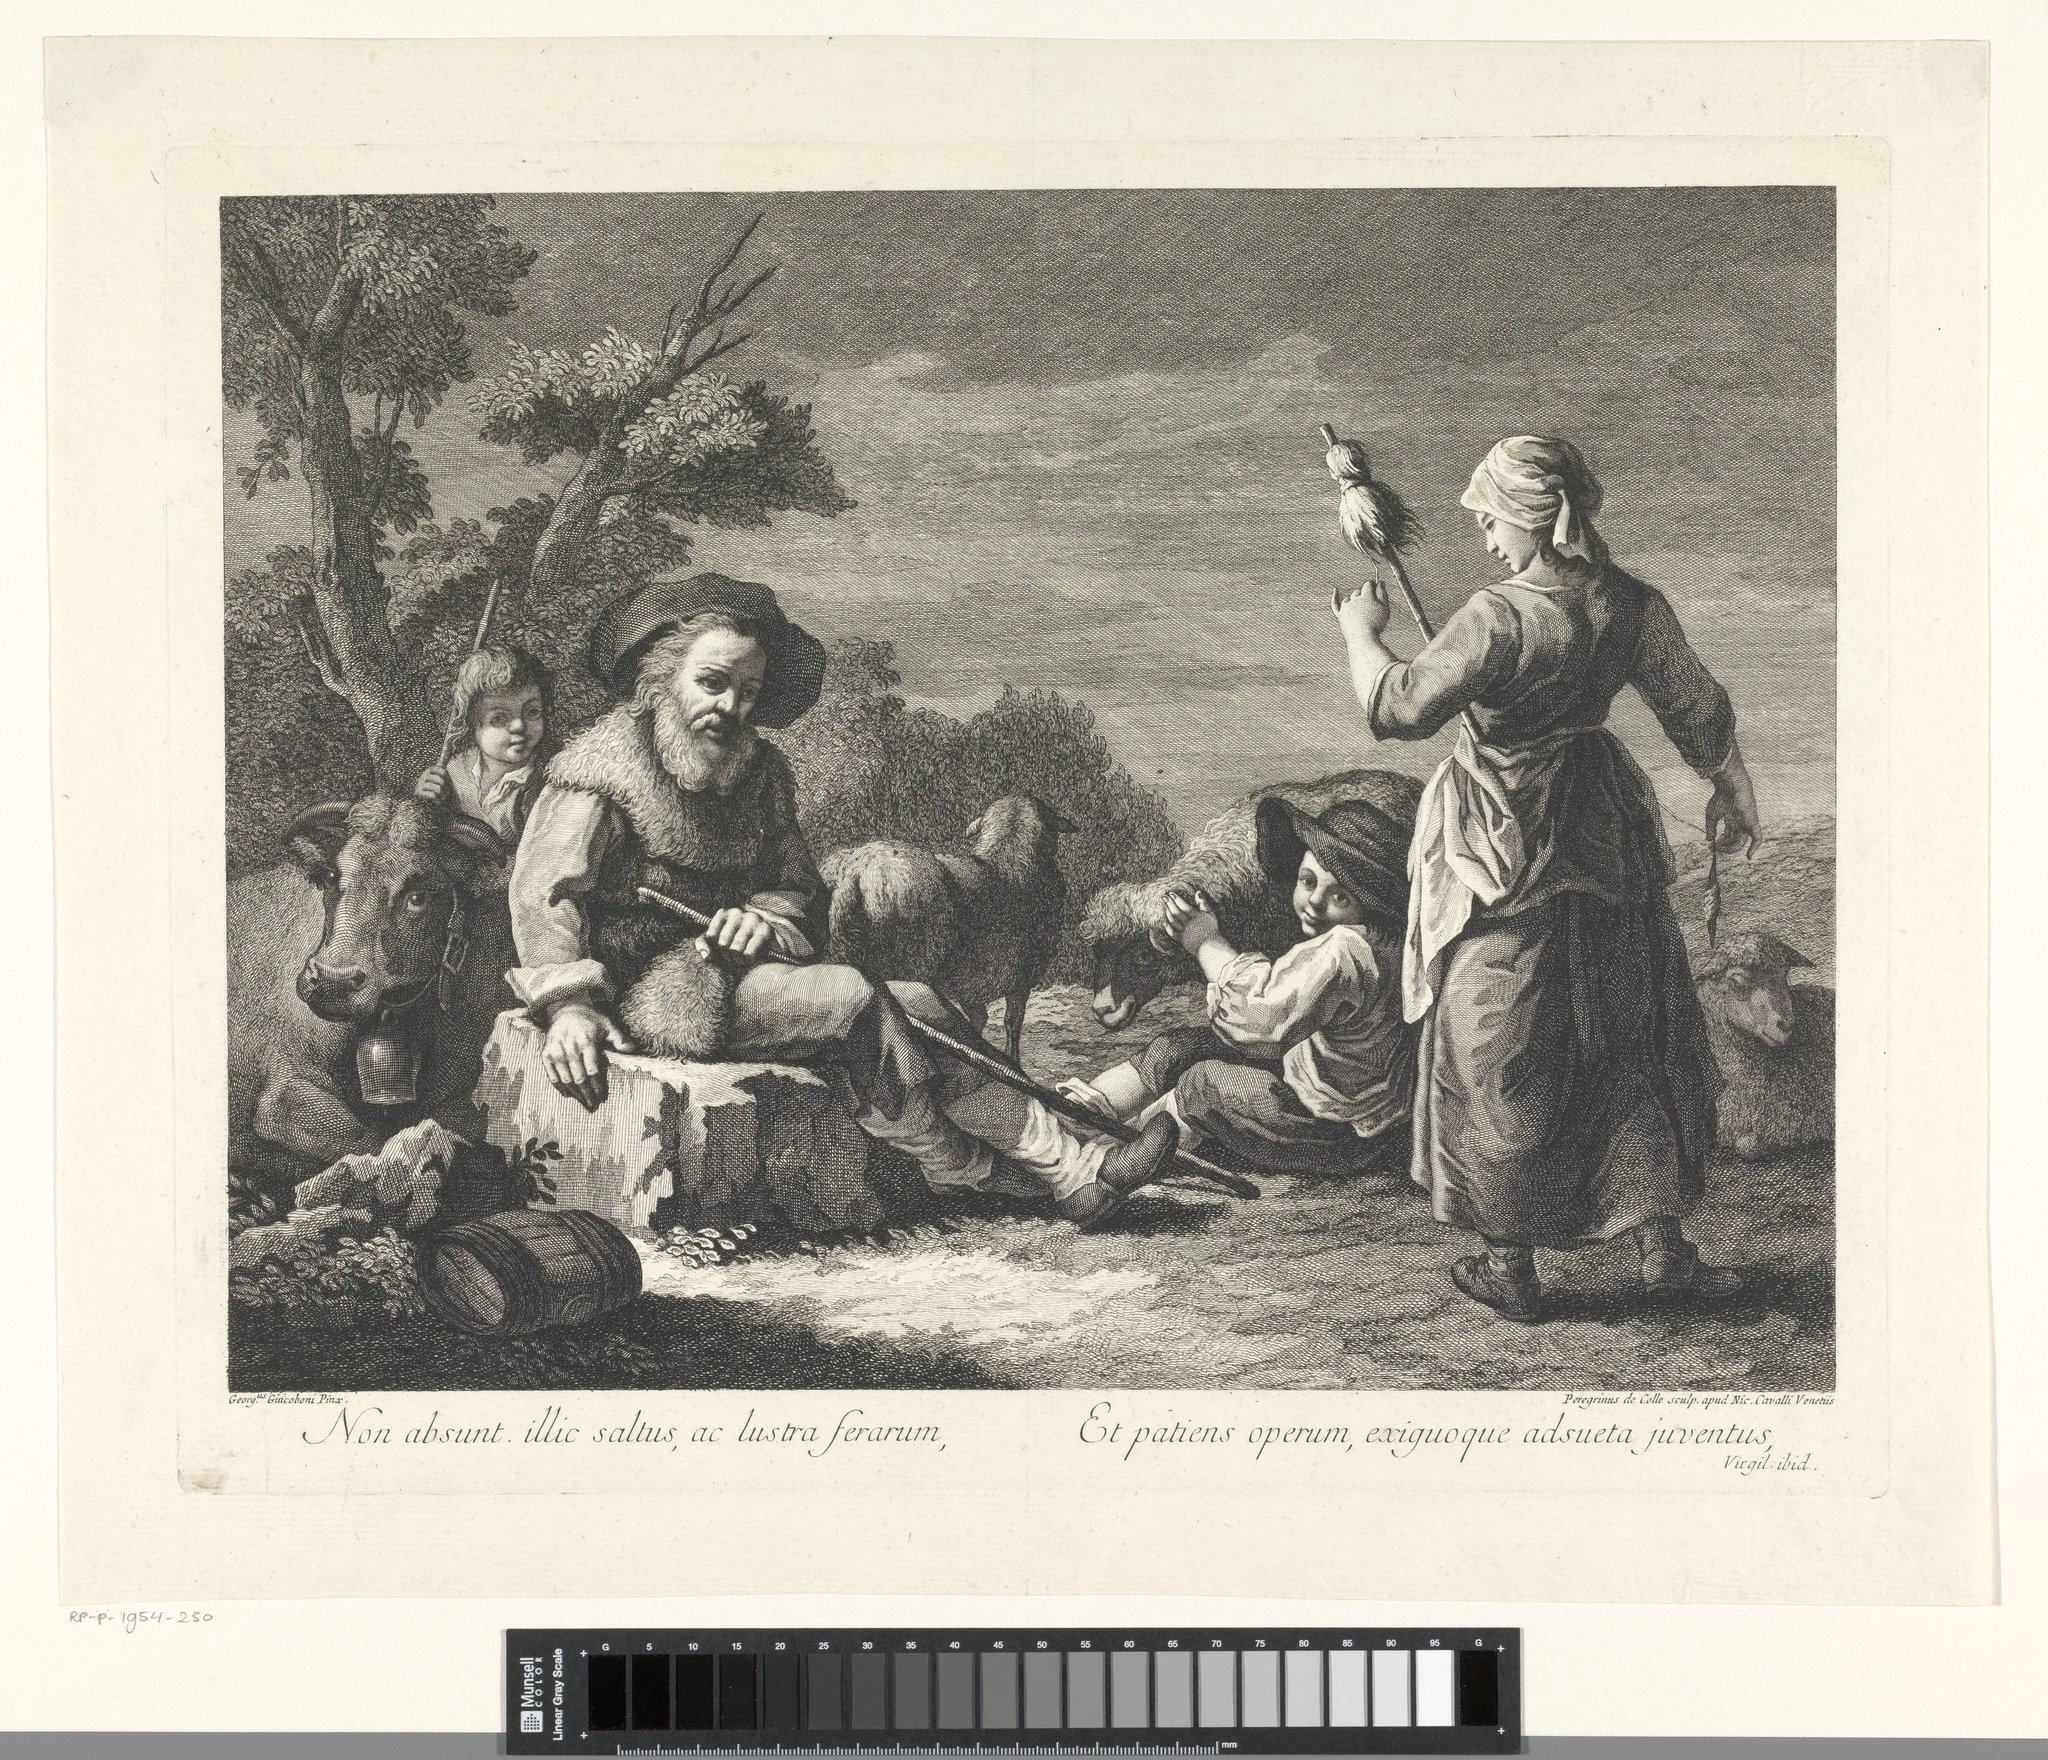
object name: print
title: Herdersfamilie in landschap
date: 1747-1812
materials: paper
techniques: engraving, etching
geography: italy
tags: herding, herdsman, herdswoman, shepherd, shepherdess, cowherd, etc., spindle, herd, flock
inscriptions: collector's mark: Lugt 2028, collector's mark: Lugt 2228, collector's mark: Lugt 2760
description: Een herdersfamilie met hun kudde rust uit in een landschap. Rechts een herderin, van achteren gezien, die wol spint.